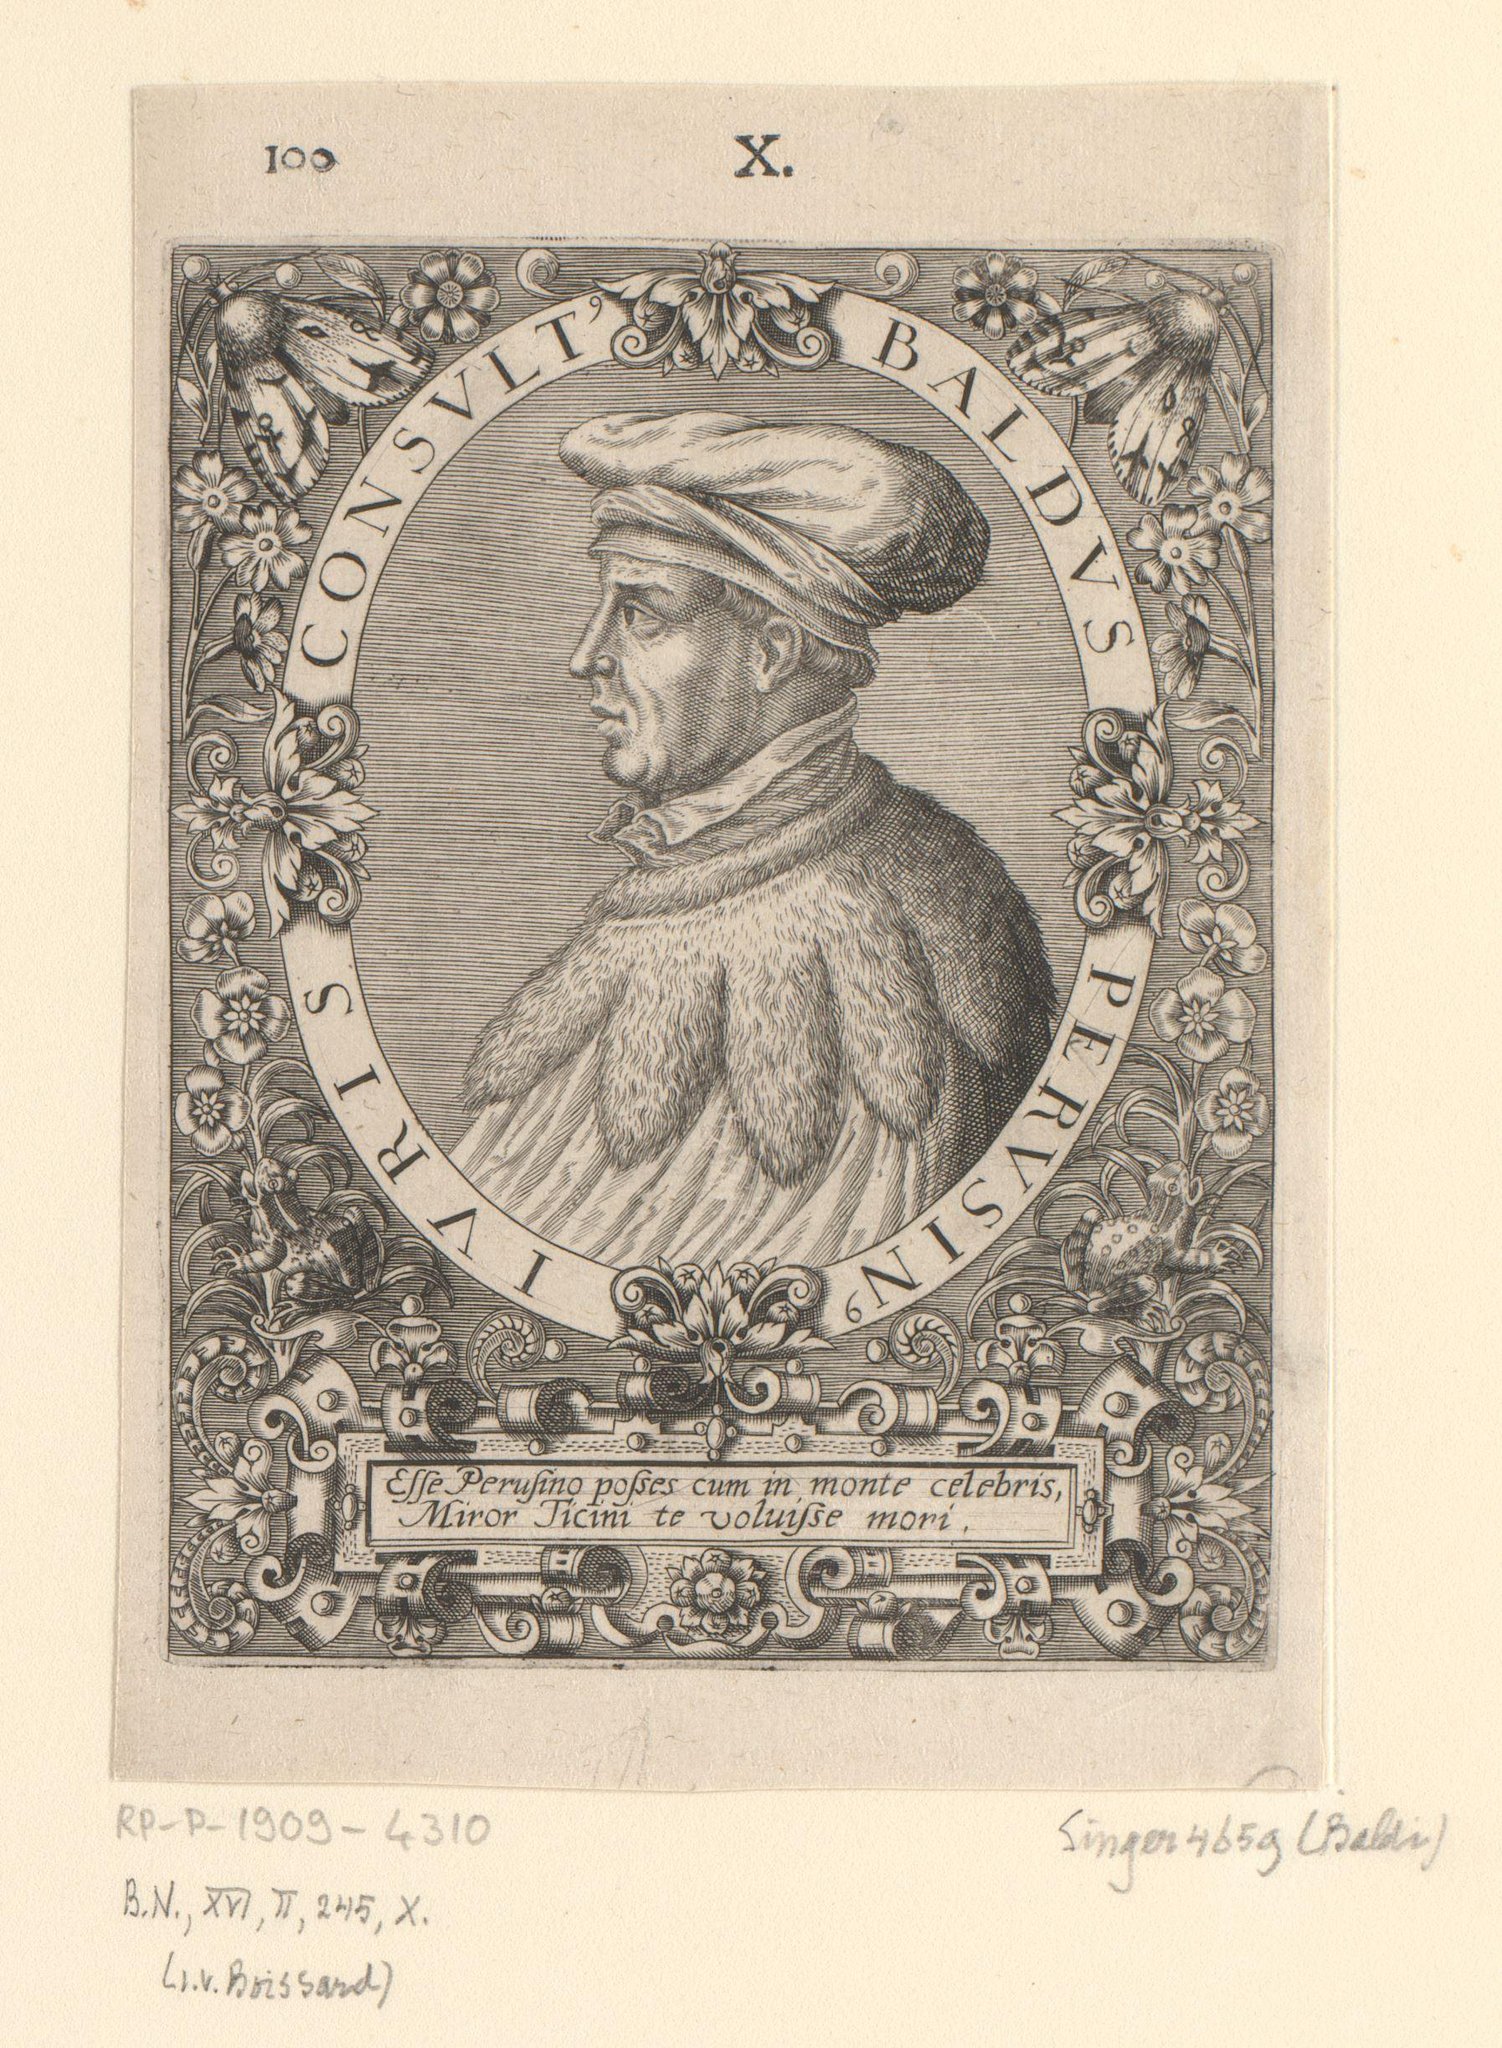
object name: print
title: Portret van Baldus de Ubaldis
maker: jean jacques boissard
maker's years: 1528-1598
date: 1597-1599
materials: paper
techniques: engraving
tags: perugia (stad), pavia, jurist, baldus de ubaldis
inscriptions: collector's mark: Lugt 2228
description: Portret van de Italiaanse rechtsgeleerde Baldus de Ubaldis, in ovaal met randschrift. In de sierlijst zijn insecten, kikkers en bloemen verwerkt.